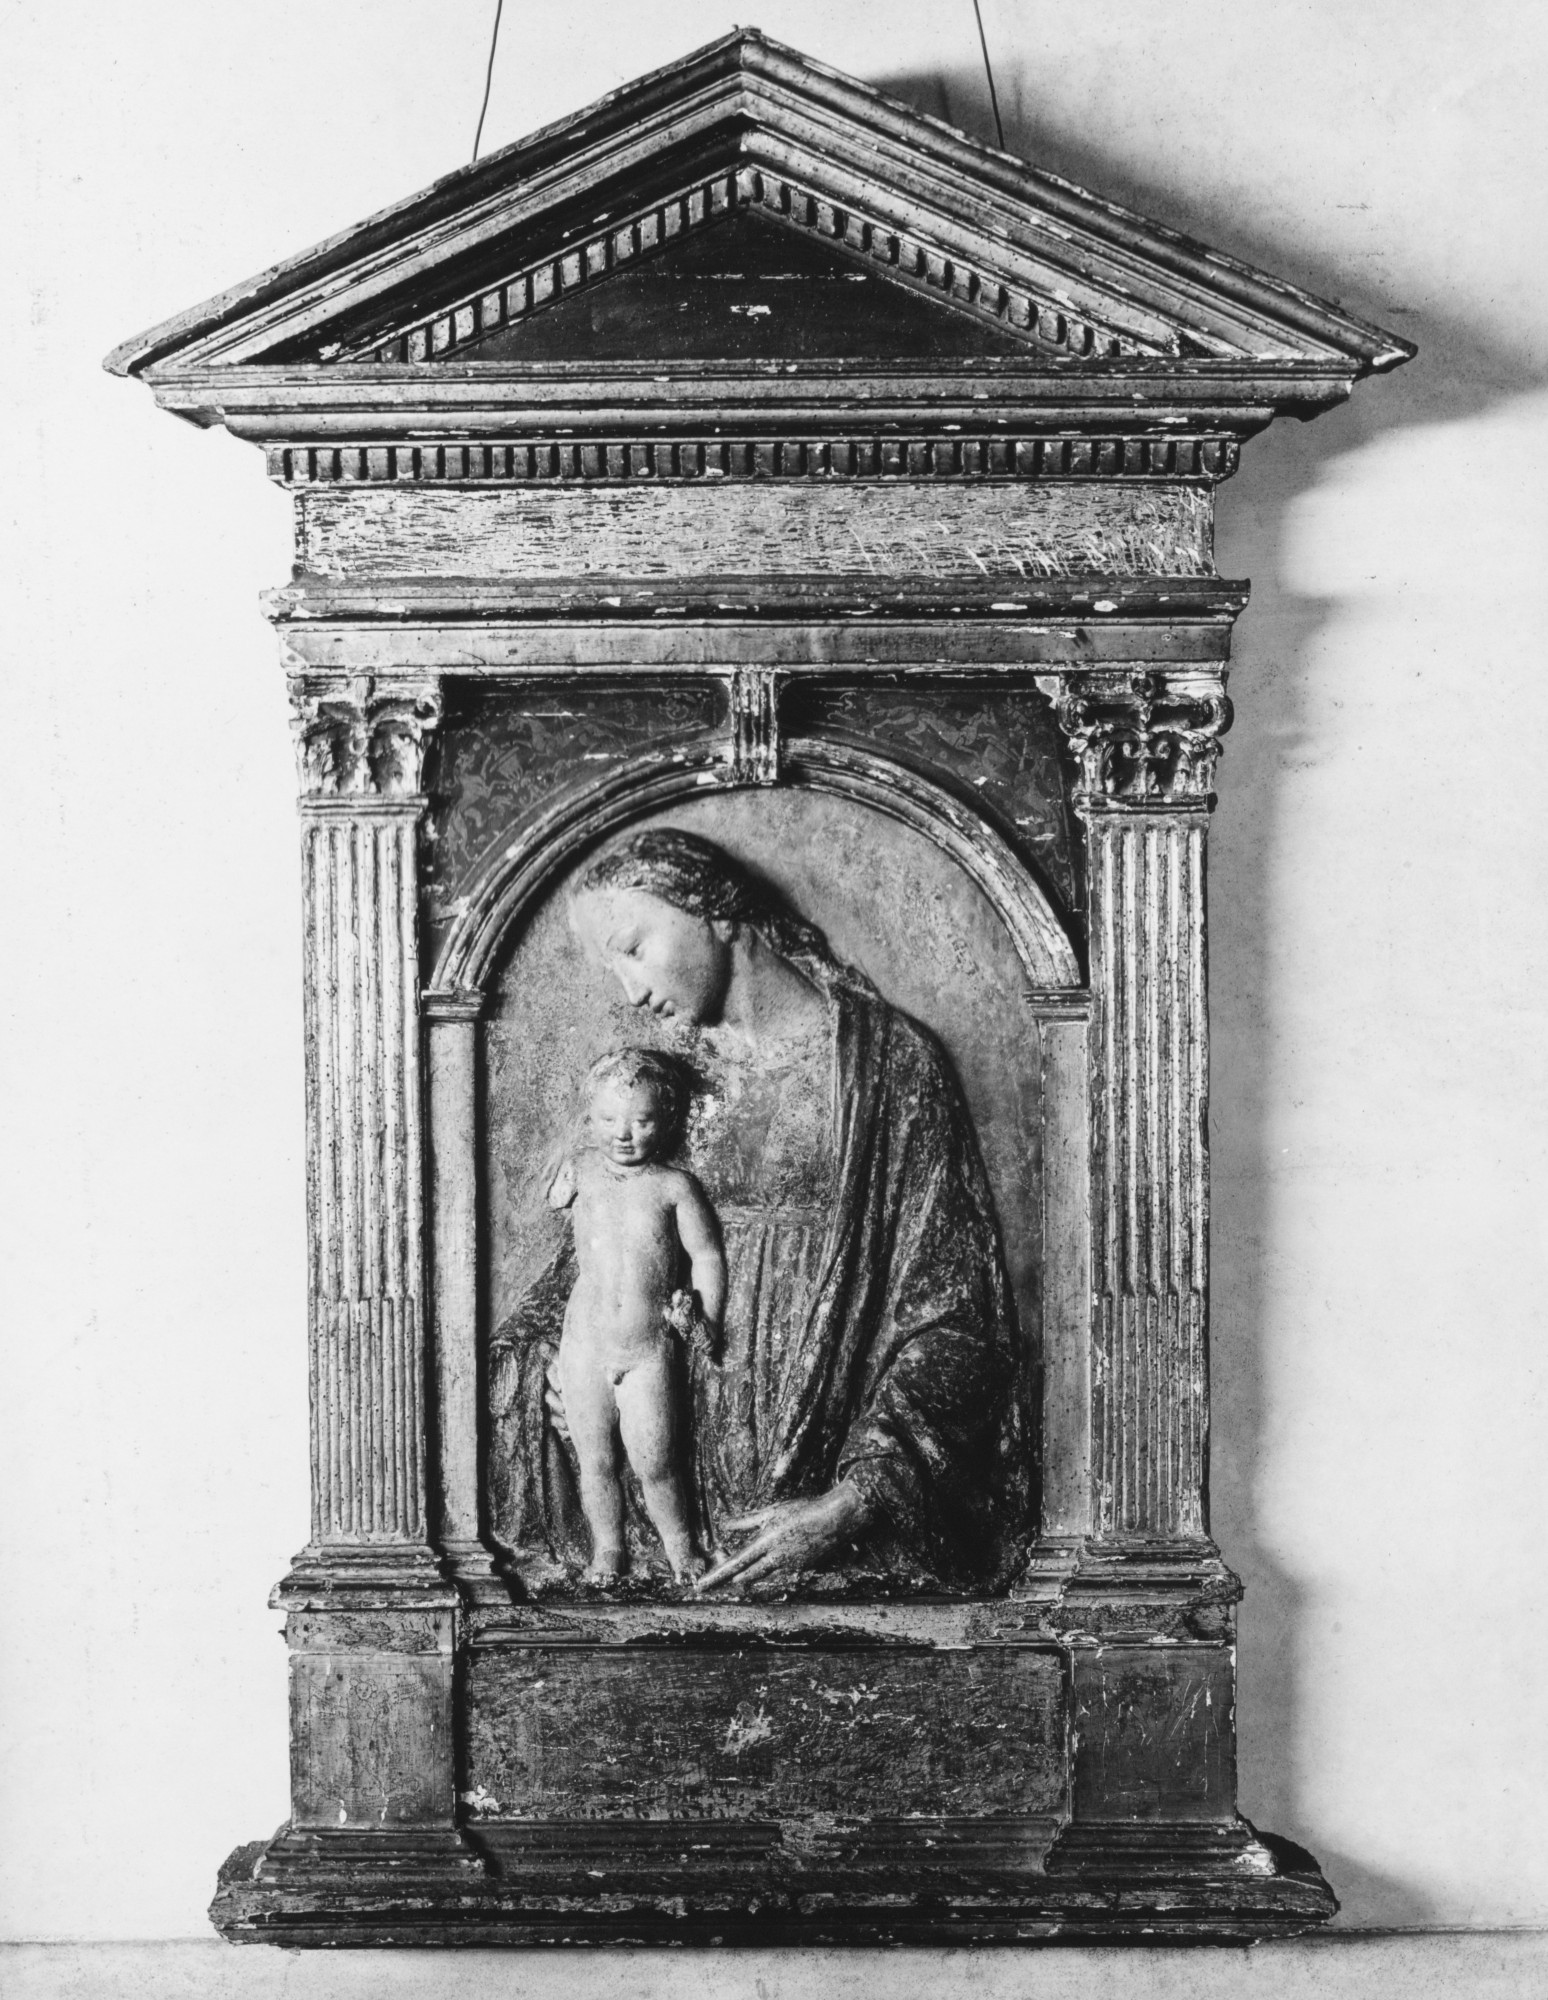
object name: relief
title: Virgin and Child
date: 1401-1500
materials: plaster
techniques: gilding, painting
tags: madonna and child